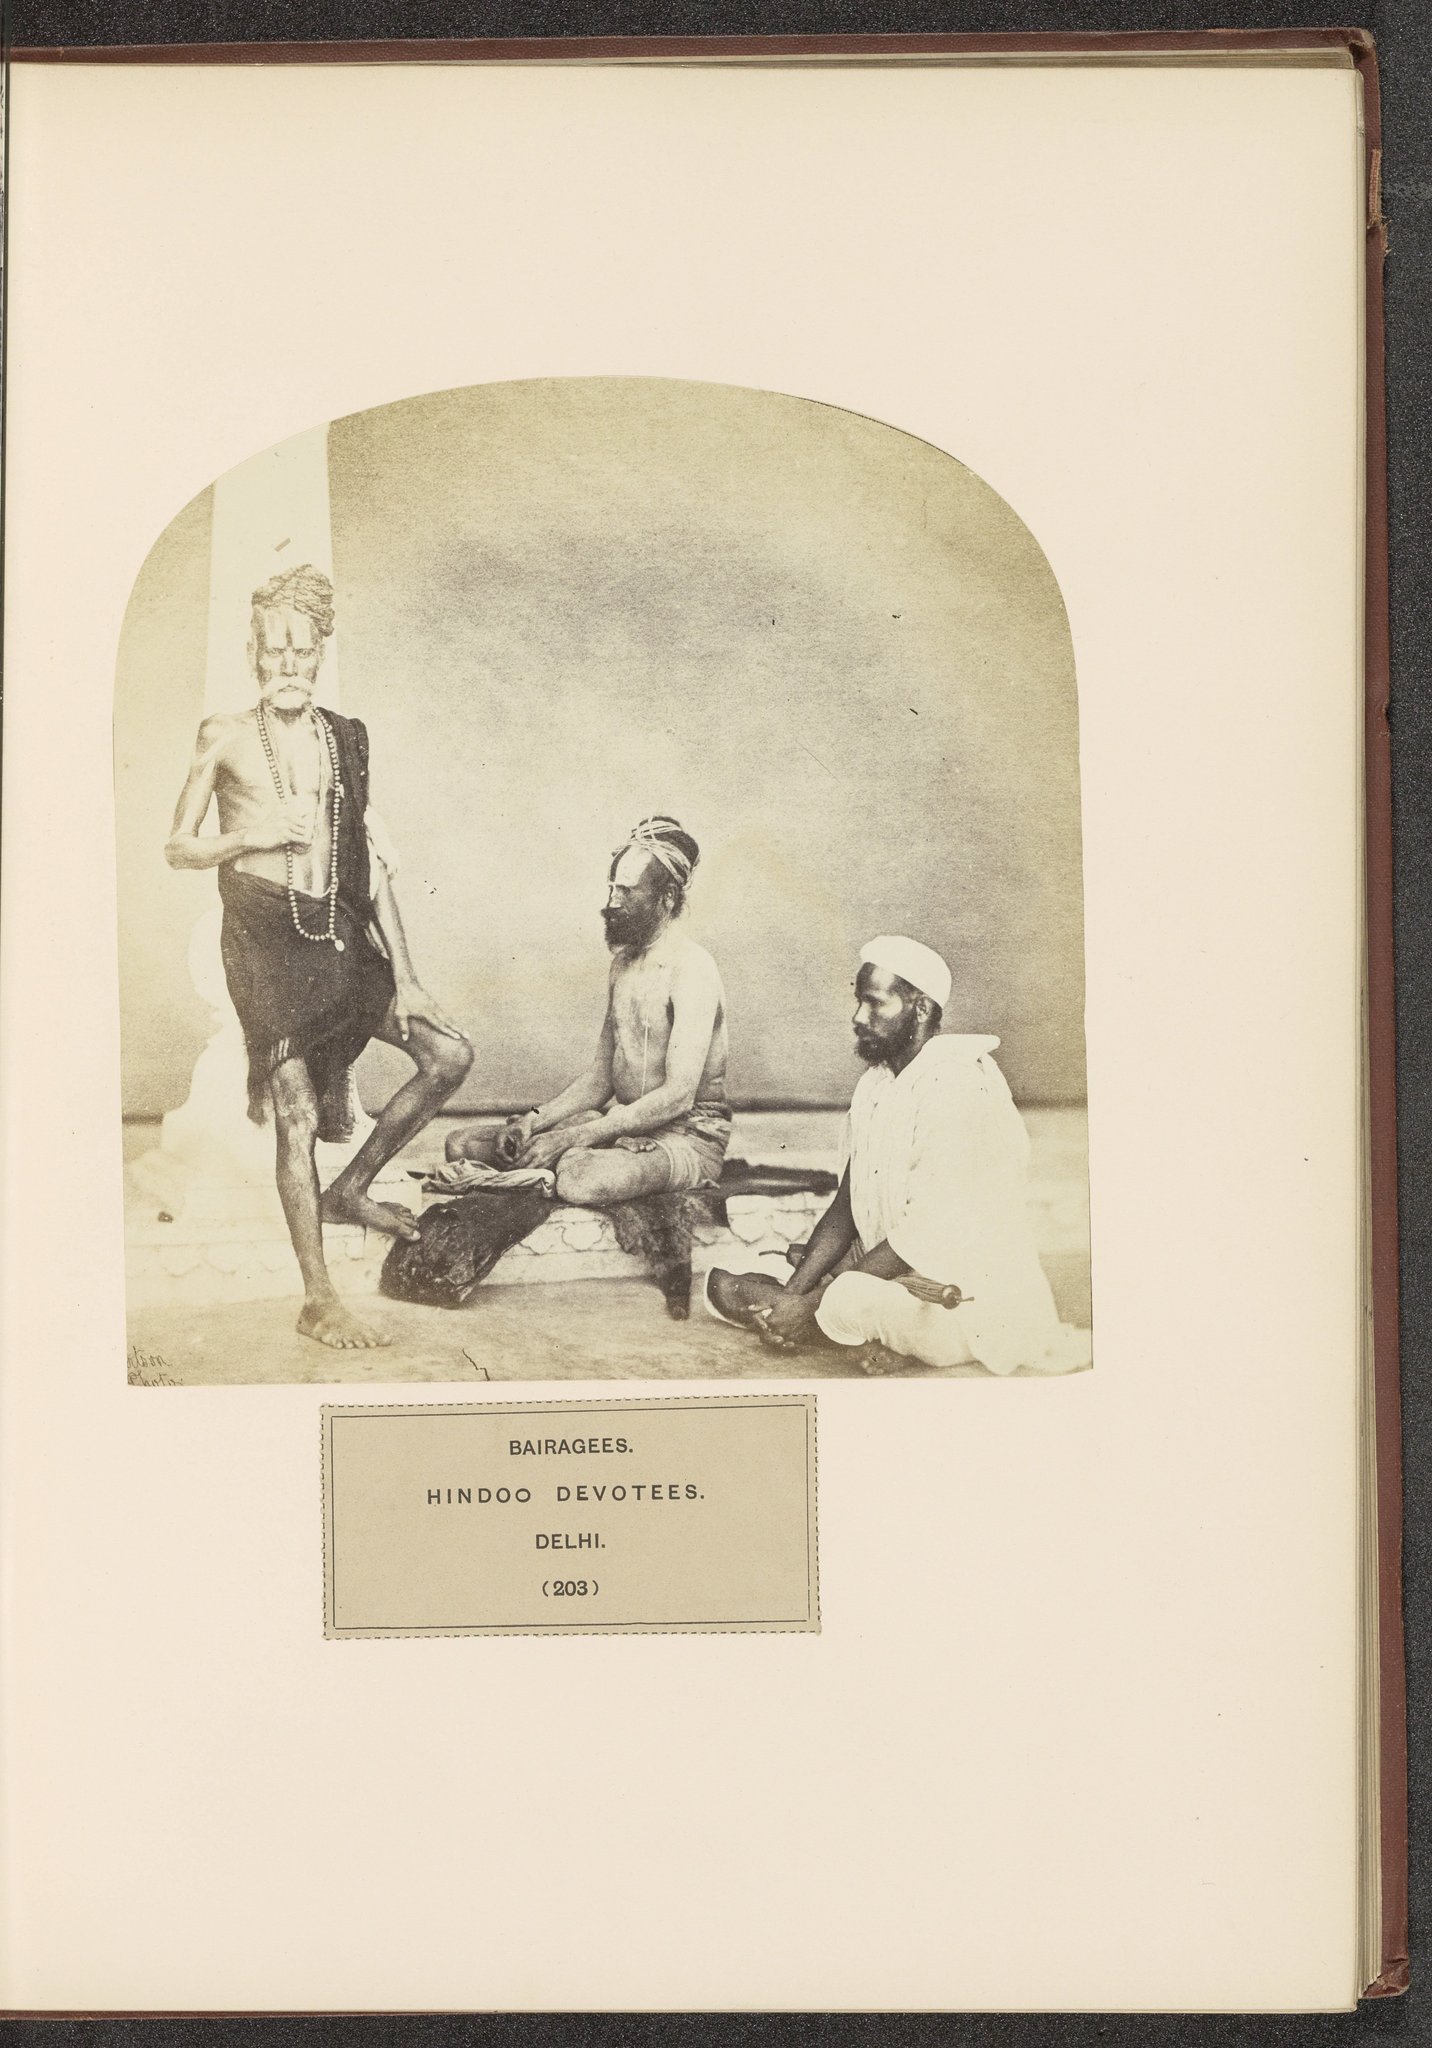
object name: photograph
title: Portrait of three mendicants in ceremonial clothes from the Bairagi community in Delhi, India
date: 1859-1869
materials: photographic support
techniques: albumen print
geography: delhi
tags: human races; peoples; nationalities, religious functionaries ~ hinduism, buddhism, jainism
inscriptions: inscription: ‘[...]rtson Photo.’, inscription: ‘BAIRAGEES./ HINDOO DEVOTEES./ DELHI.’, number: ‘(203)’